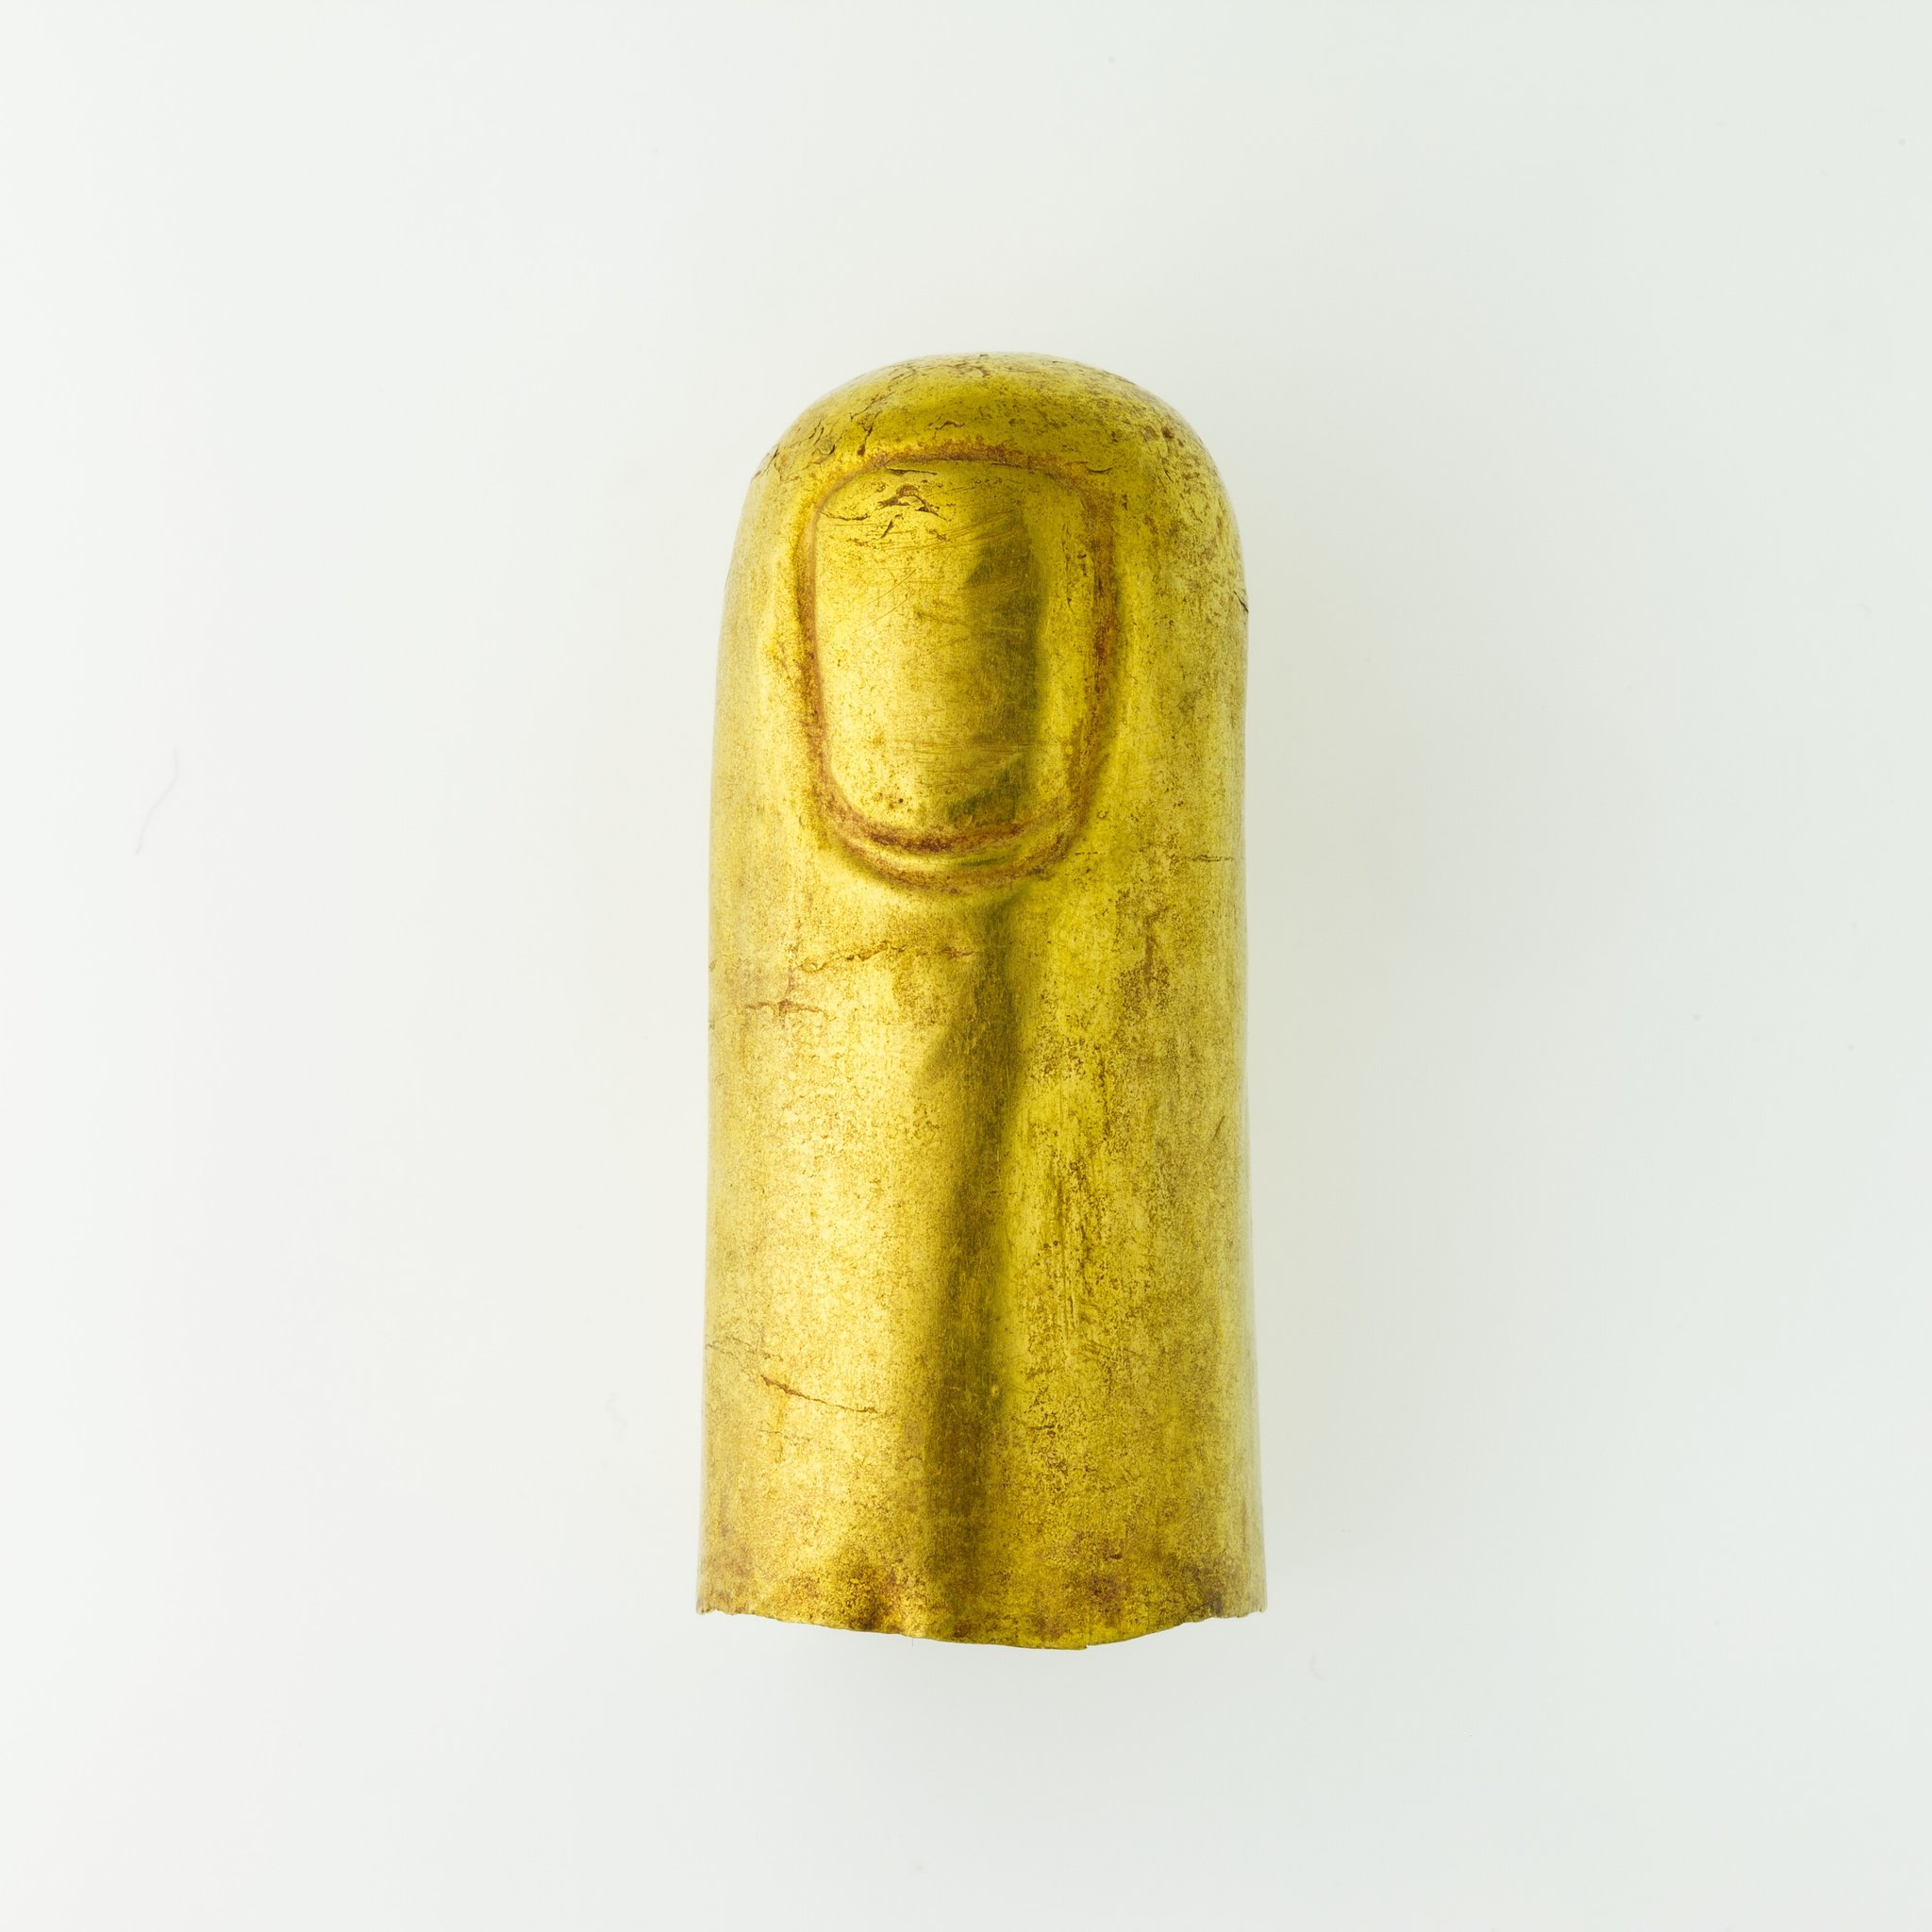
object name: toe stall, group 1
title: Toe stall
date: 1479-1425 BCE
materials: gold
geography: egypt